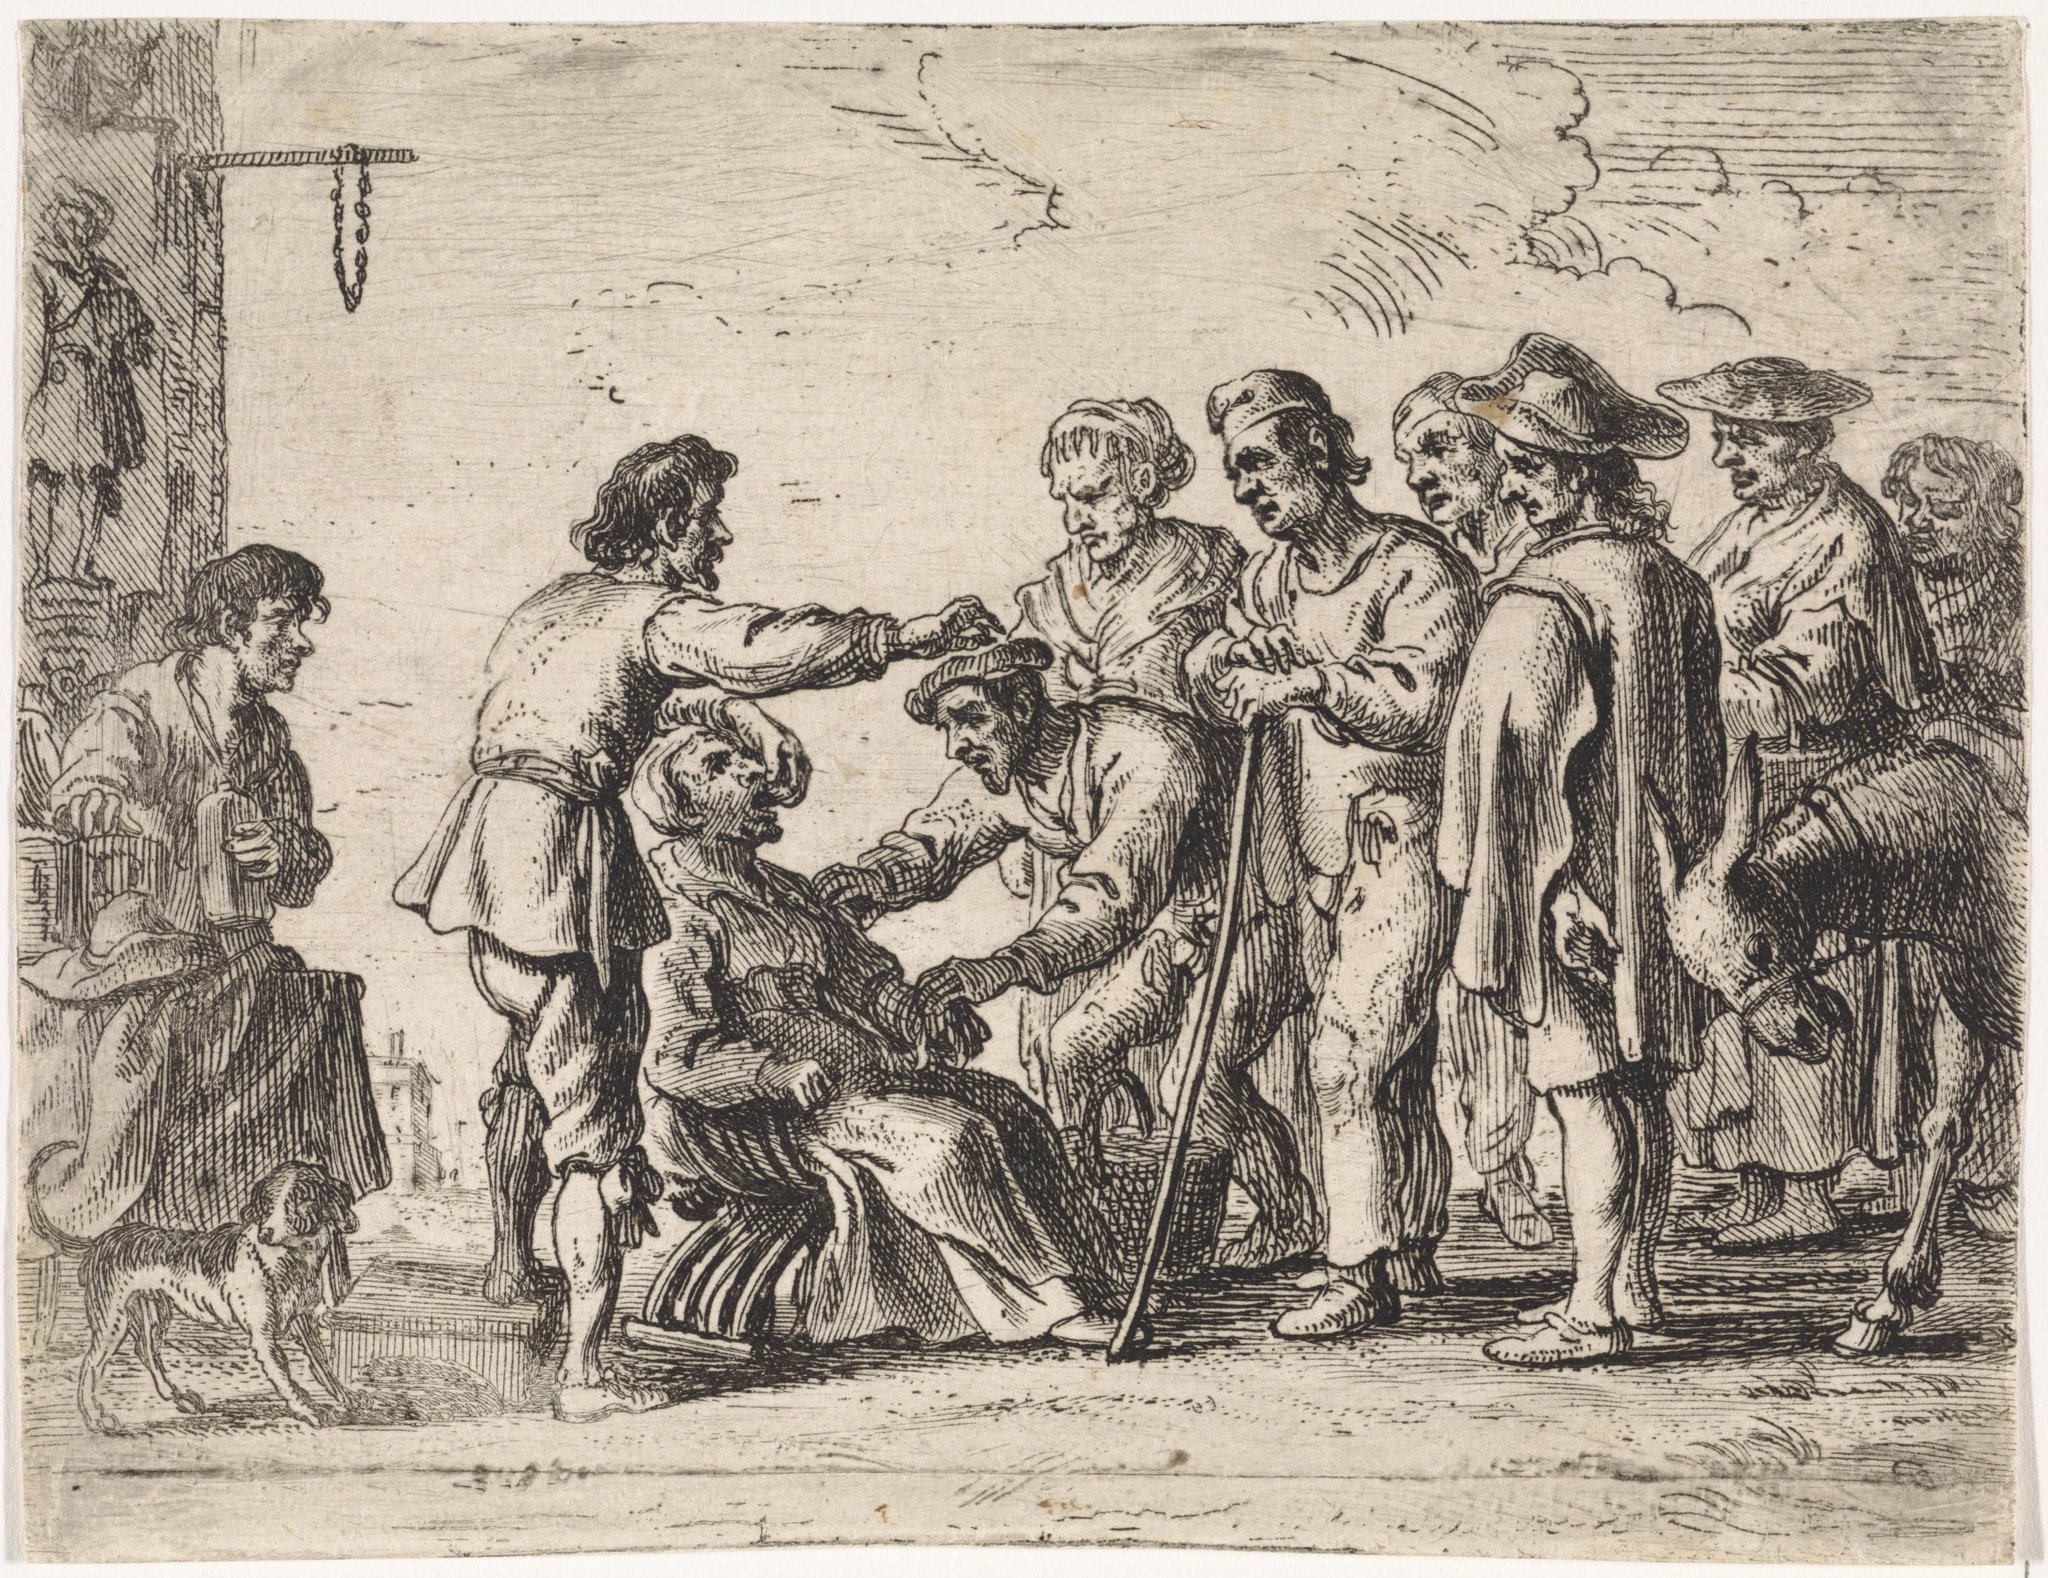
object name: print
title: De kwakzalver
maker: cornelis de wael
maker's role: draughtsman, print maker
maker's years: 1592-1667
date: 1630-1648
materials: paper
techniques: engraving, etching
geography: italy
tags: ass, donkey, quack extracting teeth or molars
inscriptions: collector's mark: Lugt 2228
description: Een gezelschap kijkt toe terwijl een man de kies trekt van een oude vrouw. Rechts een ezel.